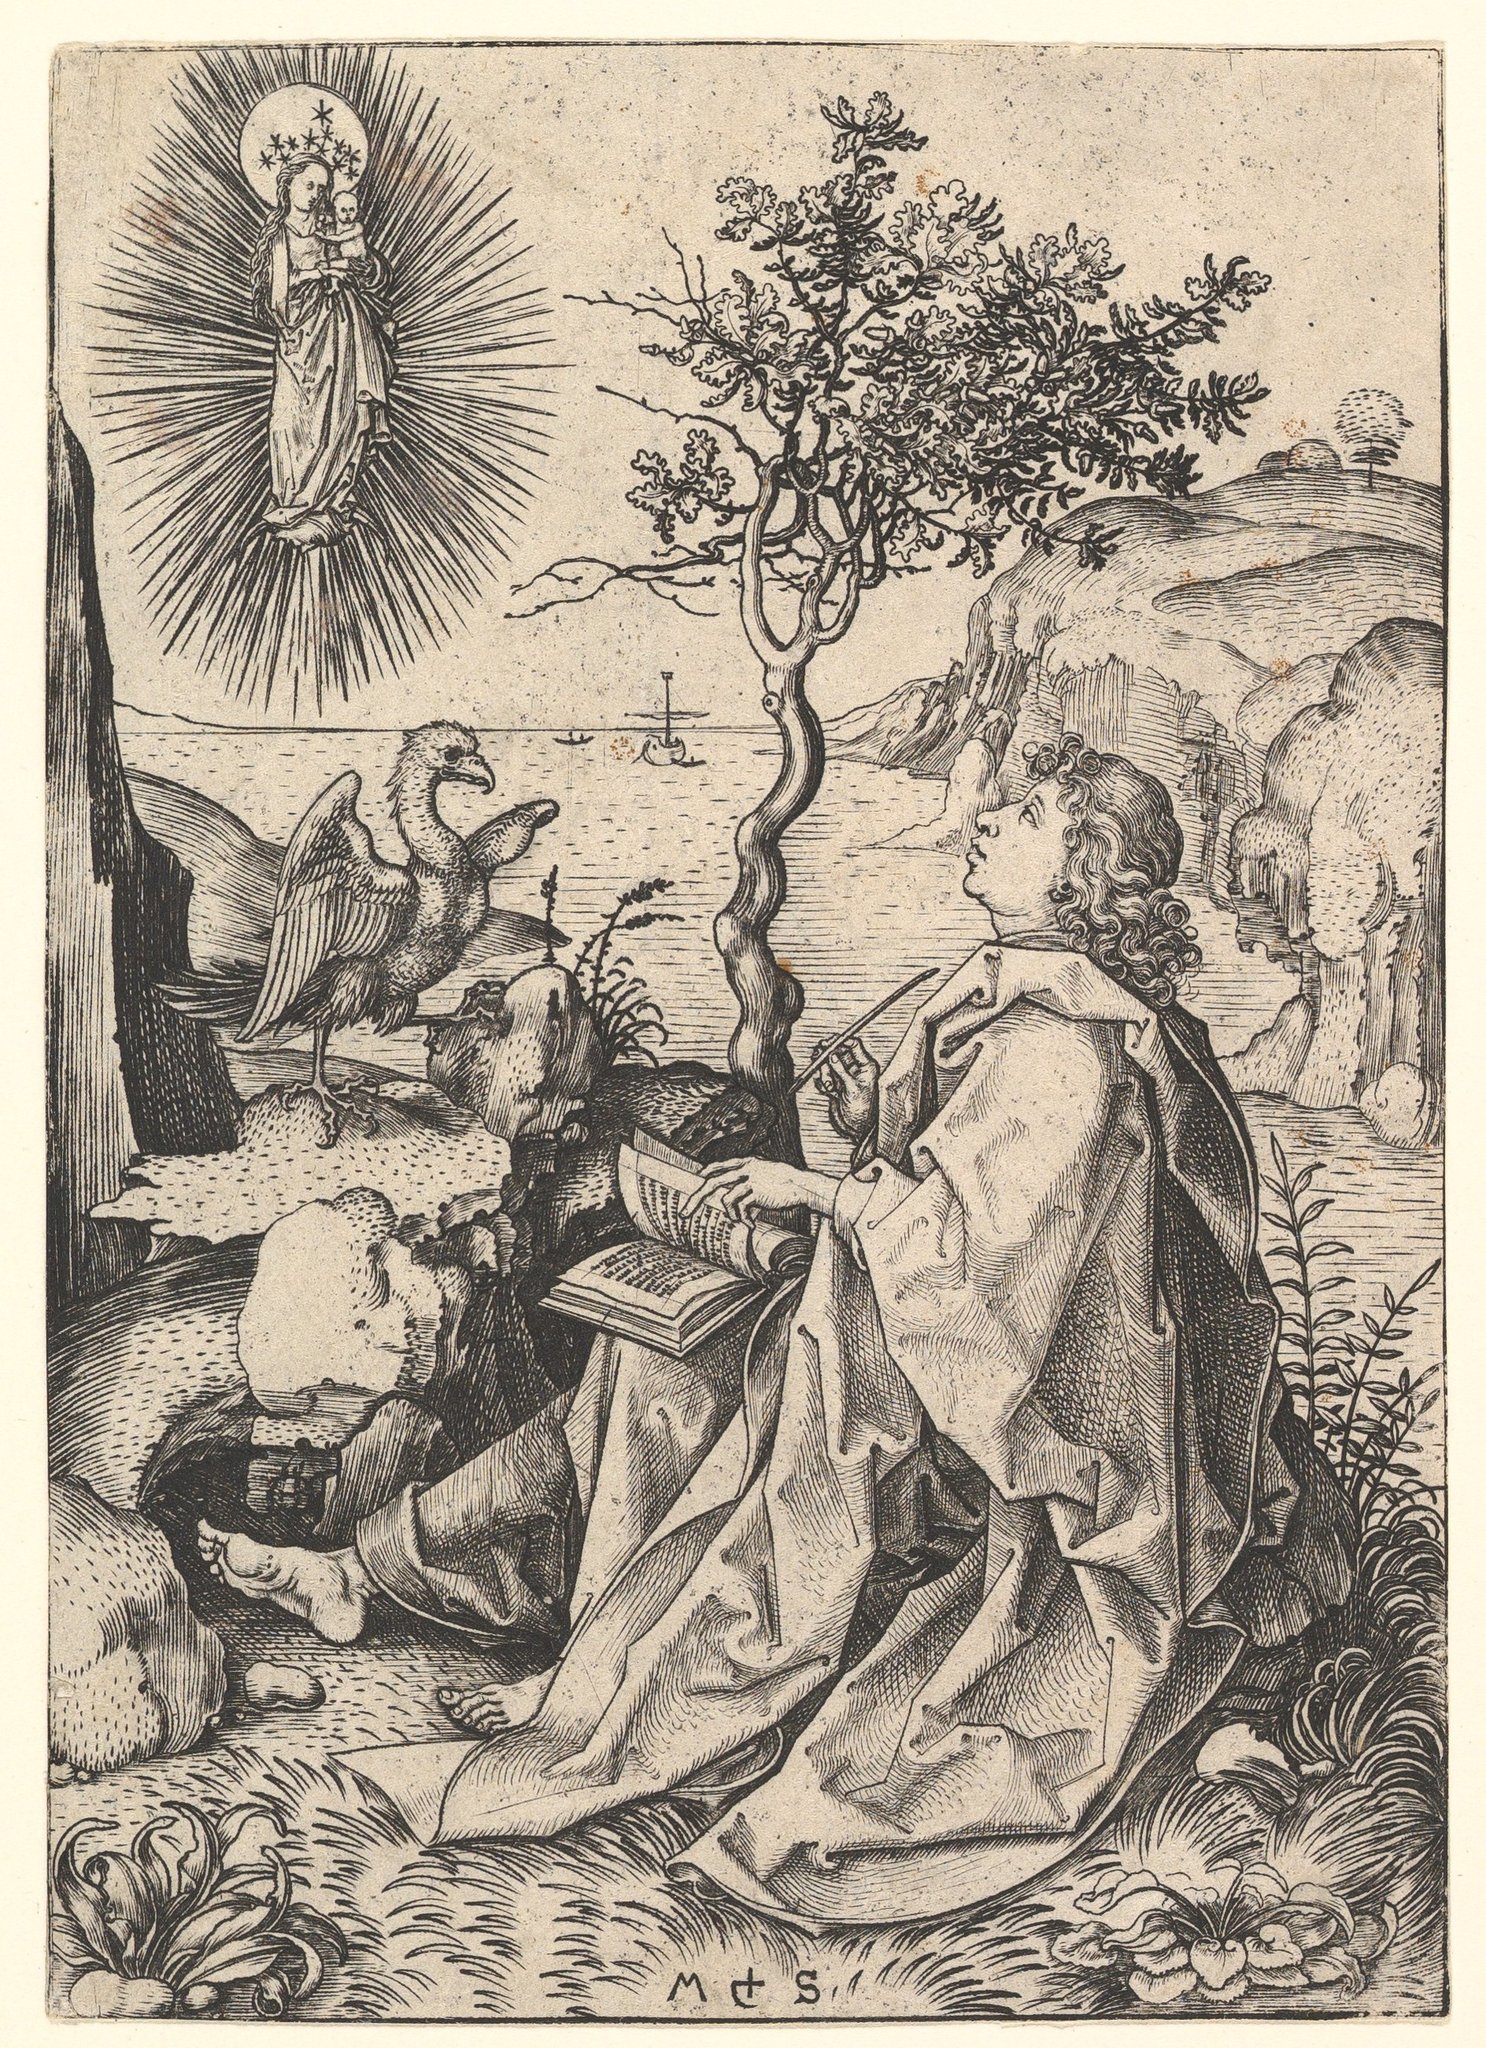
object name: print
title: Saint John on Patmos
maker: martin schongauer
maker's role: artist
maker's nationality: german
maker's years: 1430-1491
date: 1470-1491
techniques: engraving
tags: birds,trees,madonna and child,saints